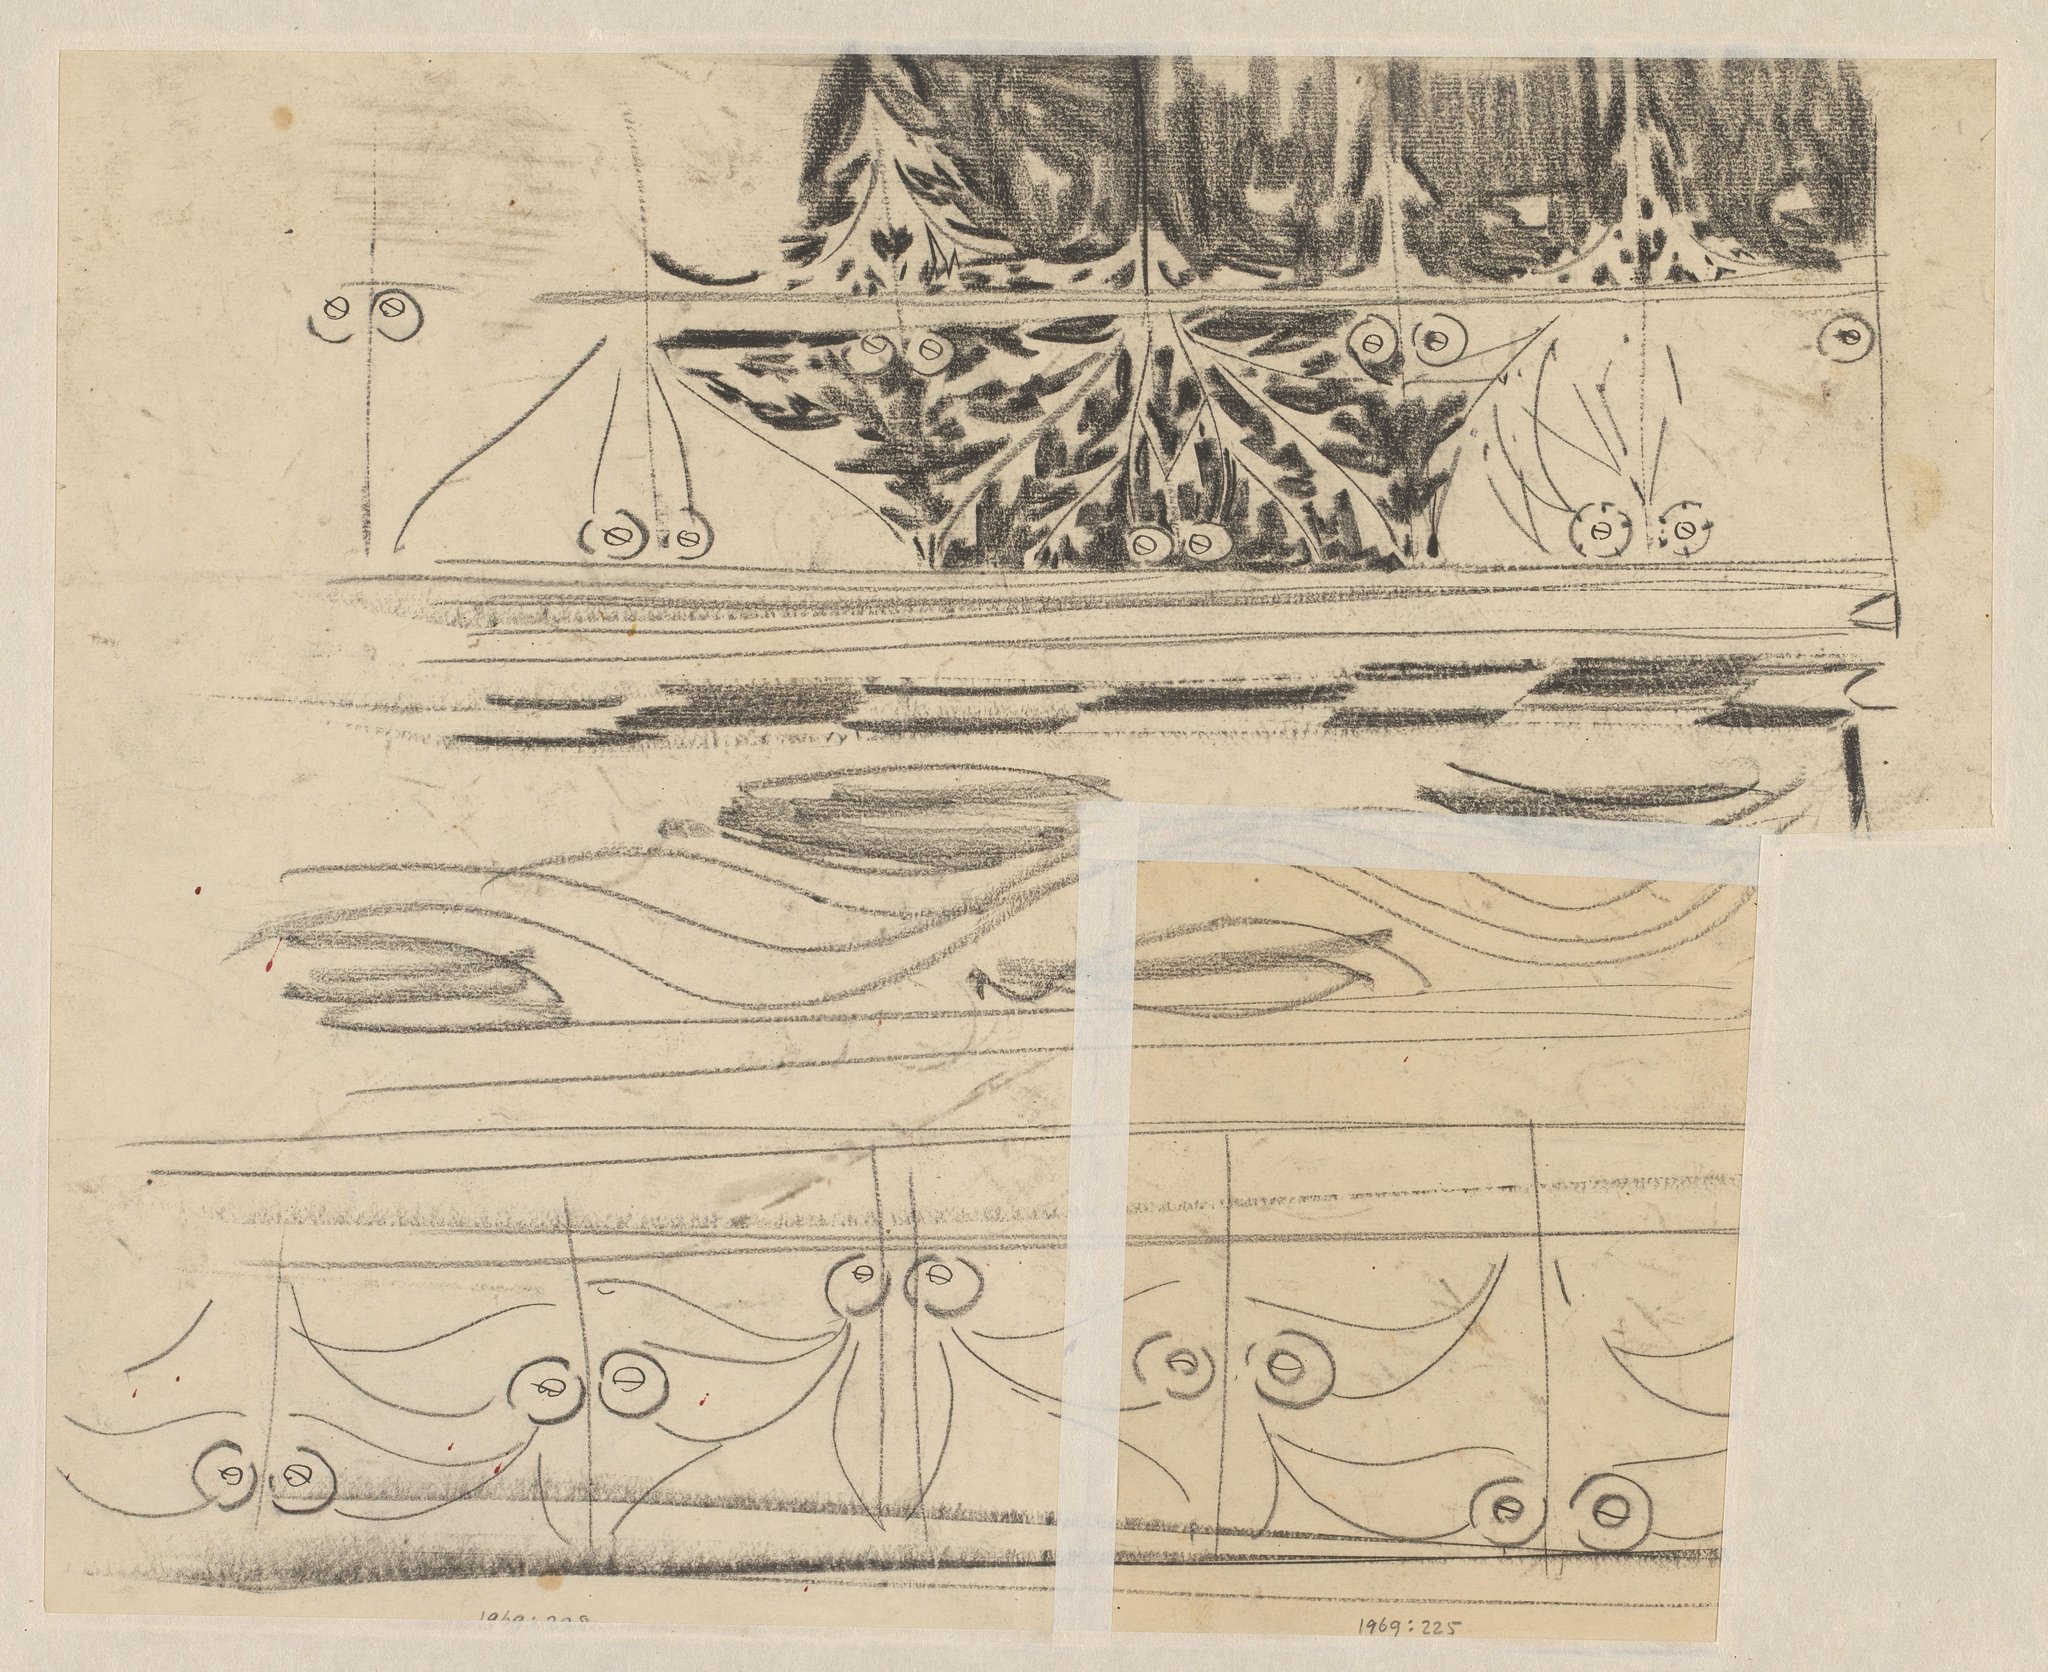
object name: drawing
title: Ornamentstudies van friezen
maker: gerrit willem dijsselhof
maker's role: designer, draughtsman, print maker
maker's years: 1866-1924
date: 1876-1924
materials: chalk, paper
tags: ornament derived from plant forms